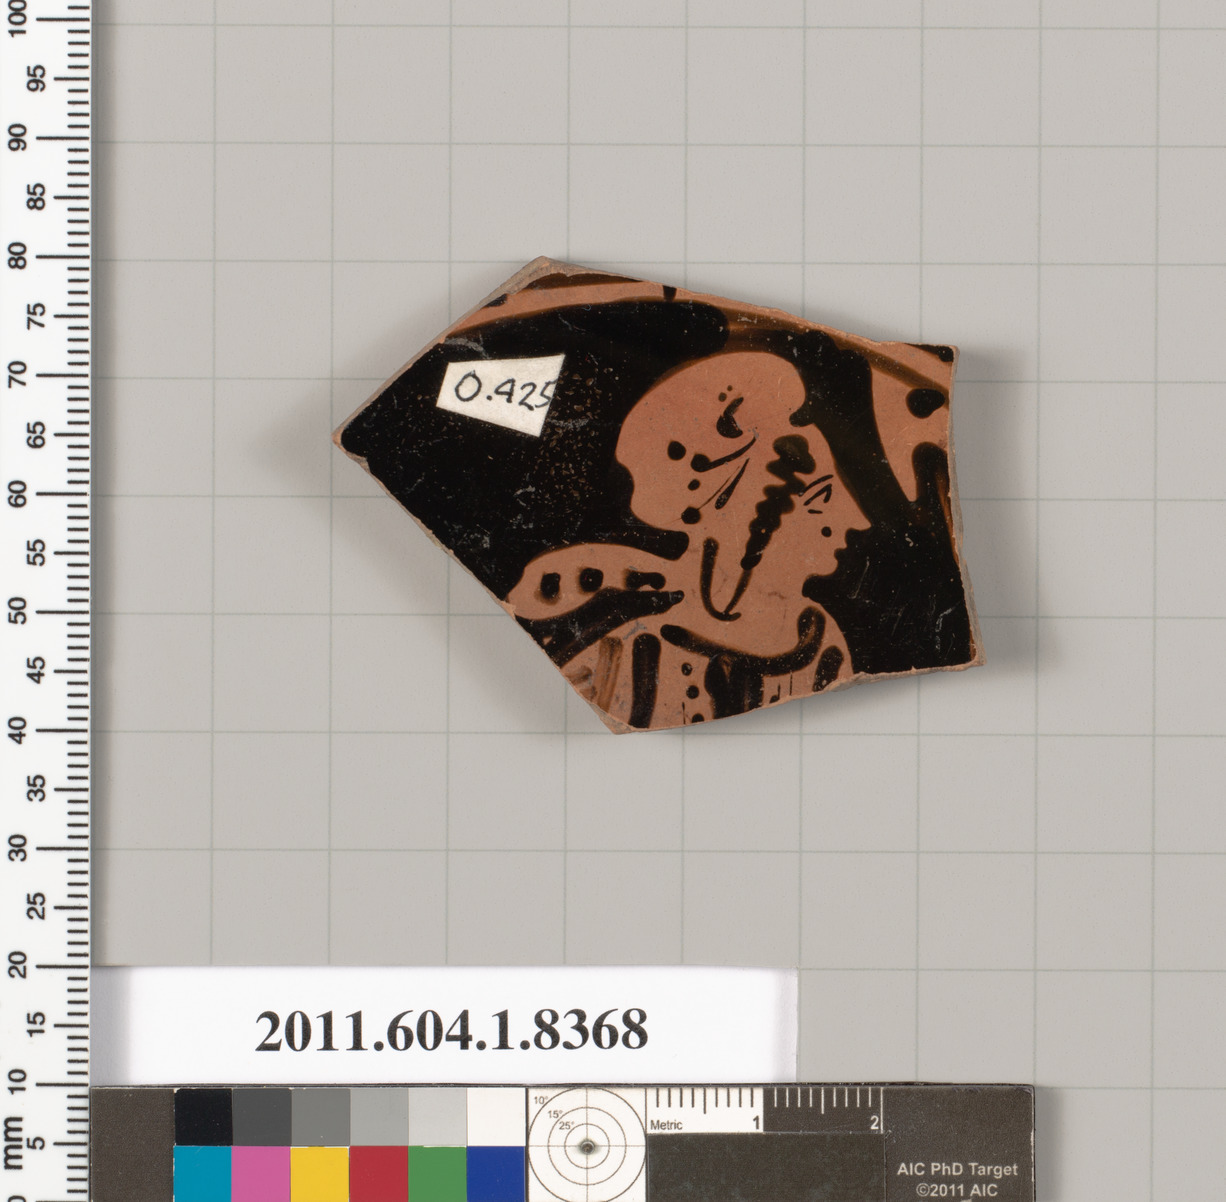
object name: kylix fragment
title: Terracotta fragment of a kylix (drinking cup)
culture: greek, attic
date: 400-351 BCE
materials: terracotta